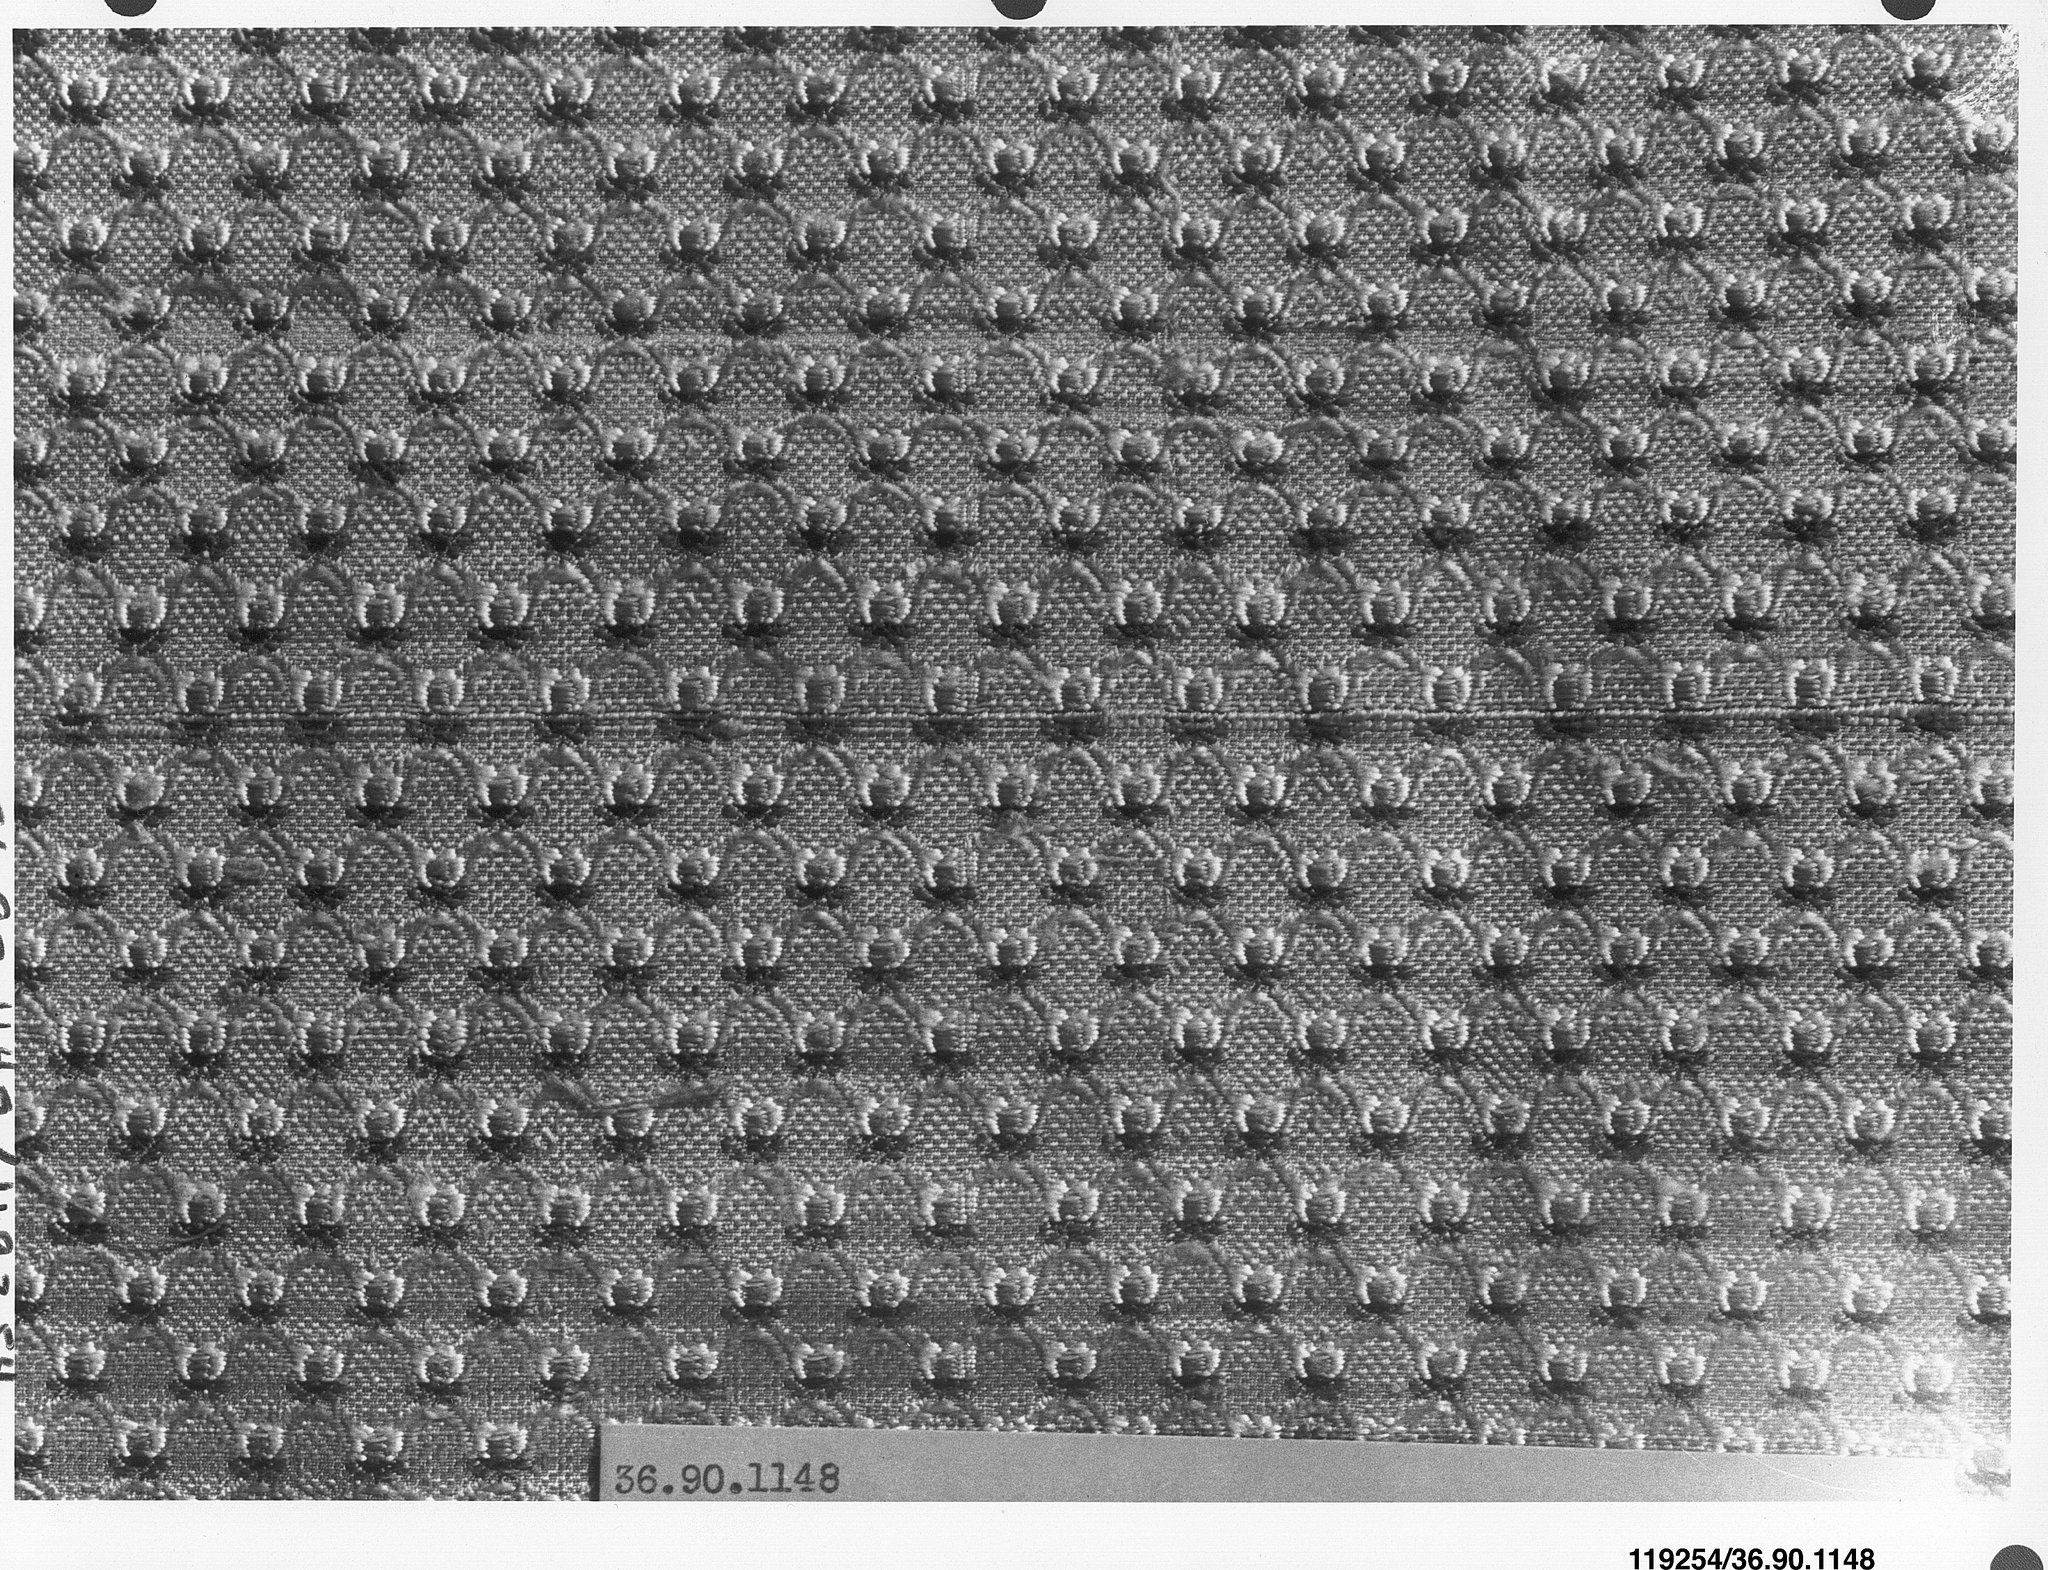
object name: piece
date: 1767-1800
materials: silk